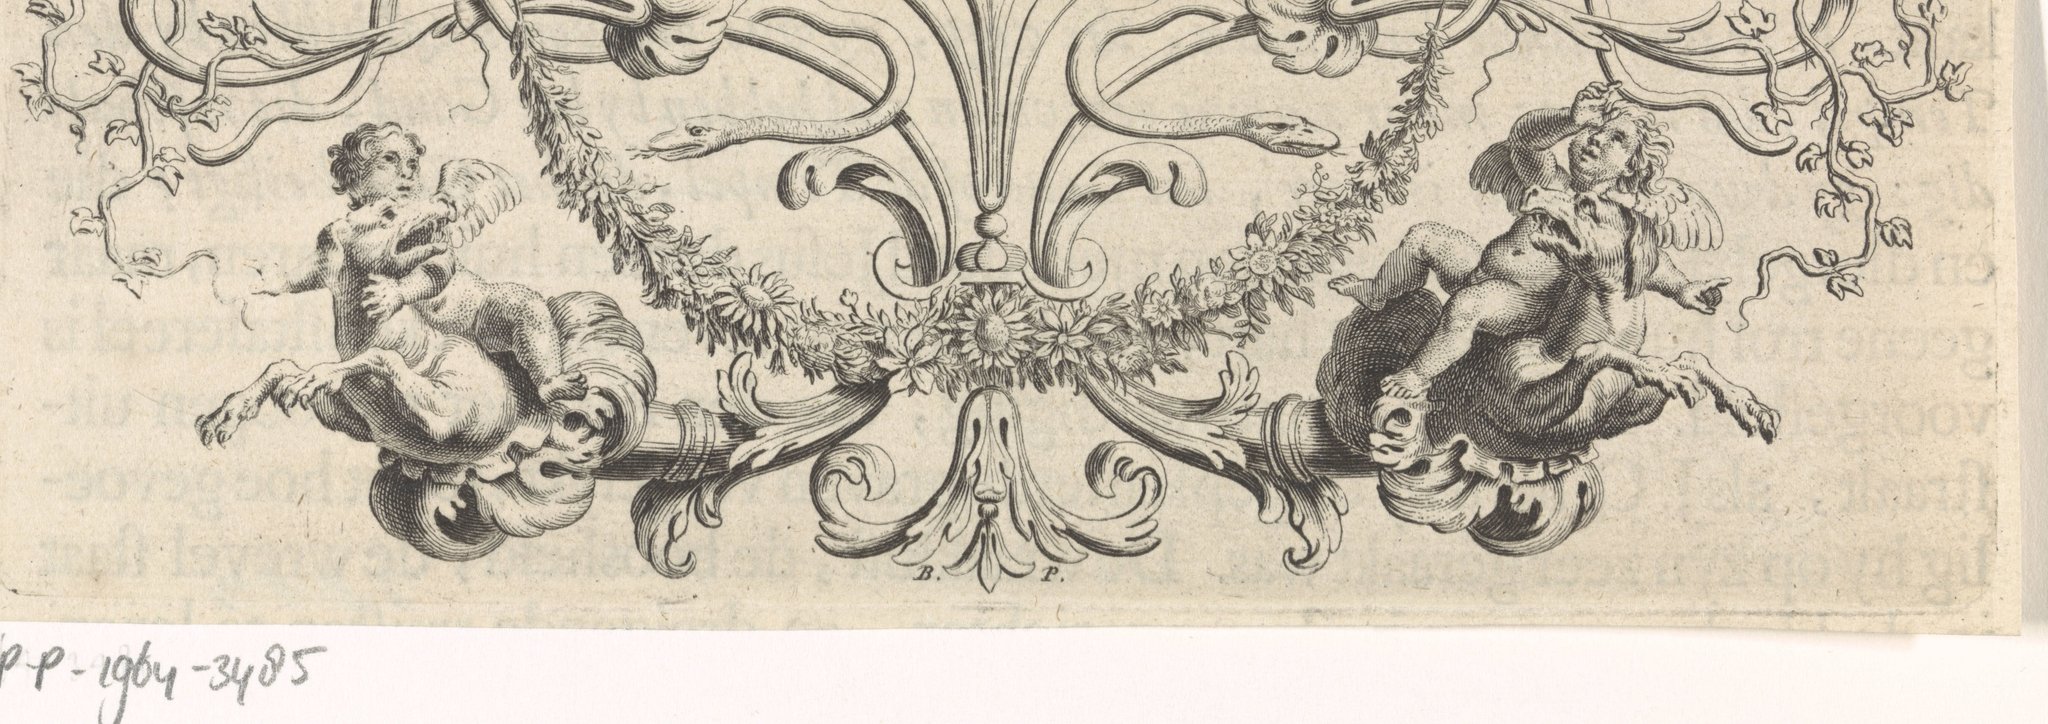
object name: print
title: Ornament met guirlande, slangen en putti die op een hond rijden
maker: bernard picart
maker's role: draughtsman, print maker, publisher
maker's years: 1673-1733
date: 1683-1733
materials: paper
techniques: engraving, etching, letterpress printing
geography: amsterdam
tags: ornament ~ hybrid animals, ornament ~ festoon, garland, foliage, tendrils, branches ~ ornament, cupids: 'amores', 'amoretti', 'putti'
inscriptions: collector's mark: Lugt 2228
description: Prent oorspronkelijk bedoeld voor: Figures de la Bible. Amsterdam, Bernard Picart, 1720. Prent ook gebruikt in: Taferelen der voornaamste geschiedenissen van het Oude en Nieuwe Testament (...) door de vermaarde kunstenaars Hoet, Houbraken, en Picart getekent (...) en met beschrijvingen uitgebreid. Den Haag: Pieter de Hondt, 1728. Prent kan mogelijk ook zijn gebruikt in andere bijbels.